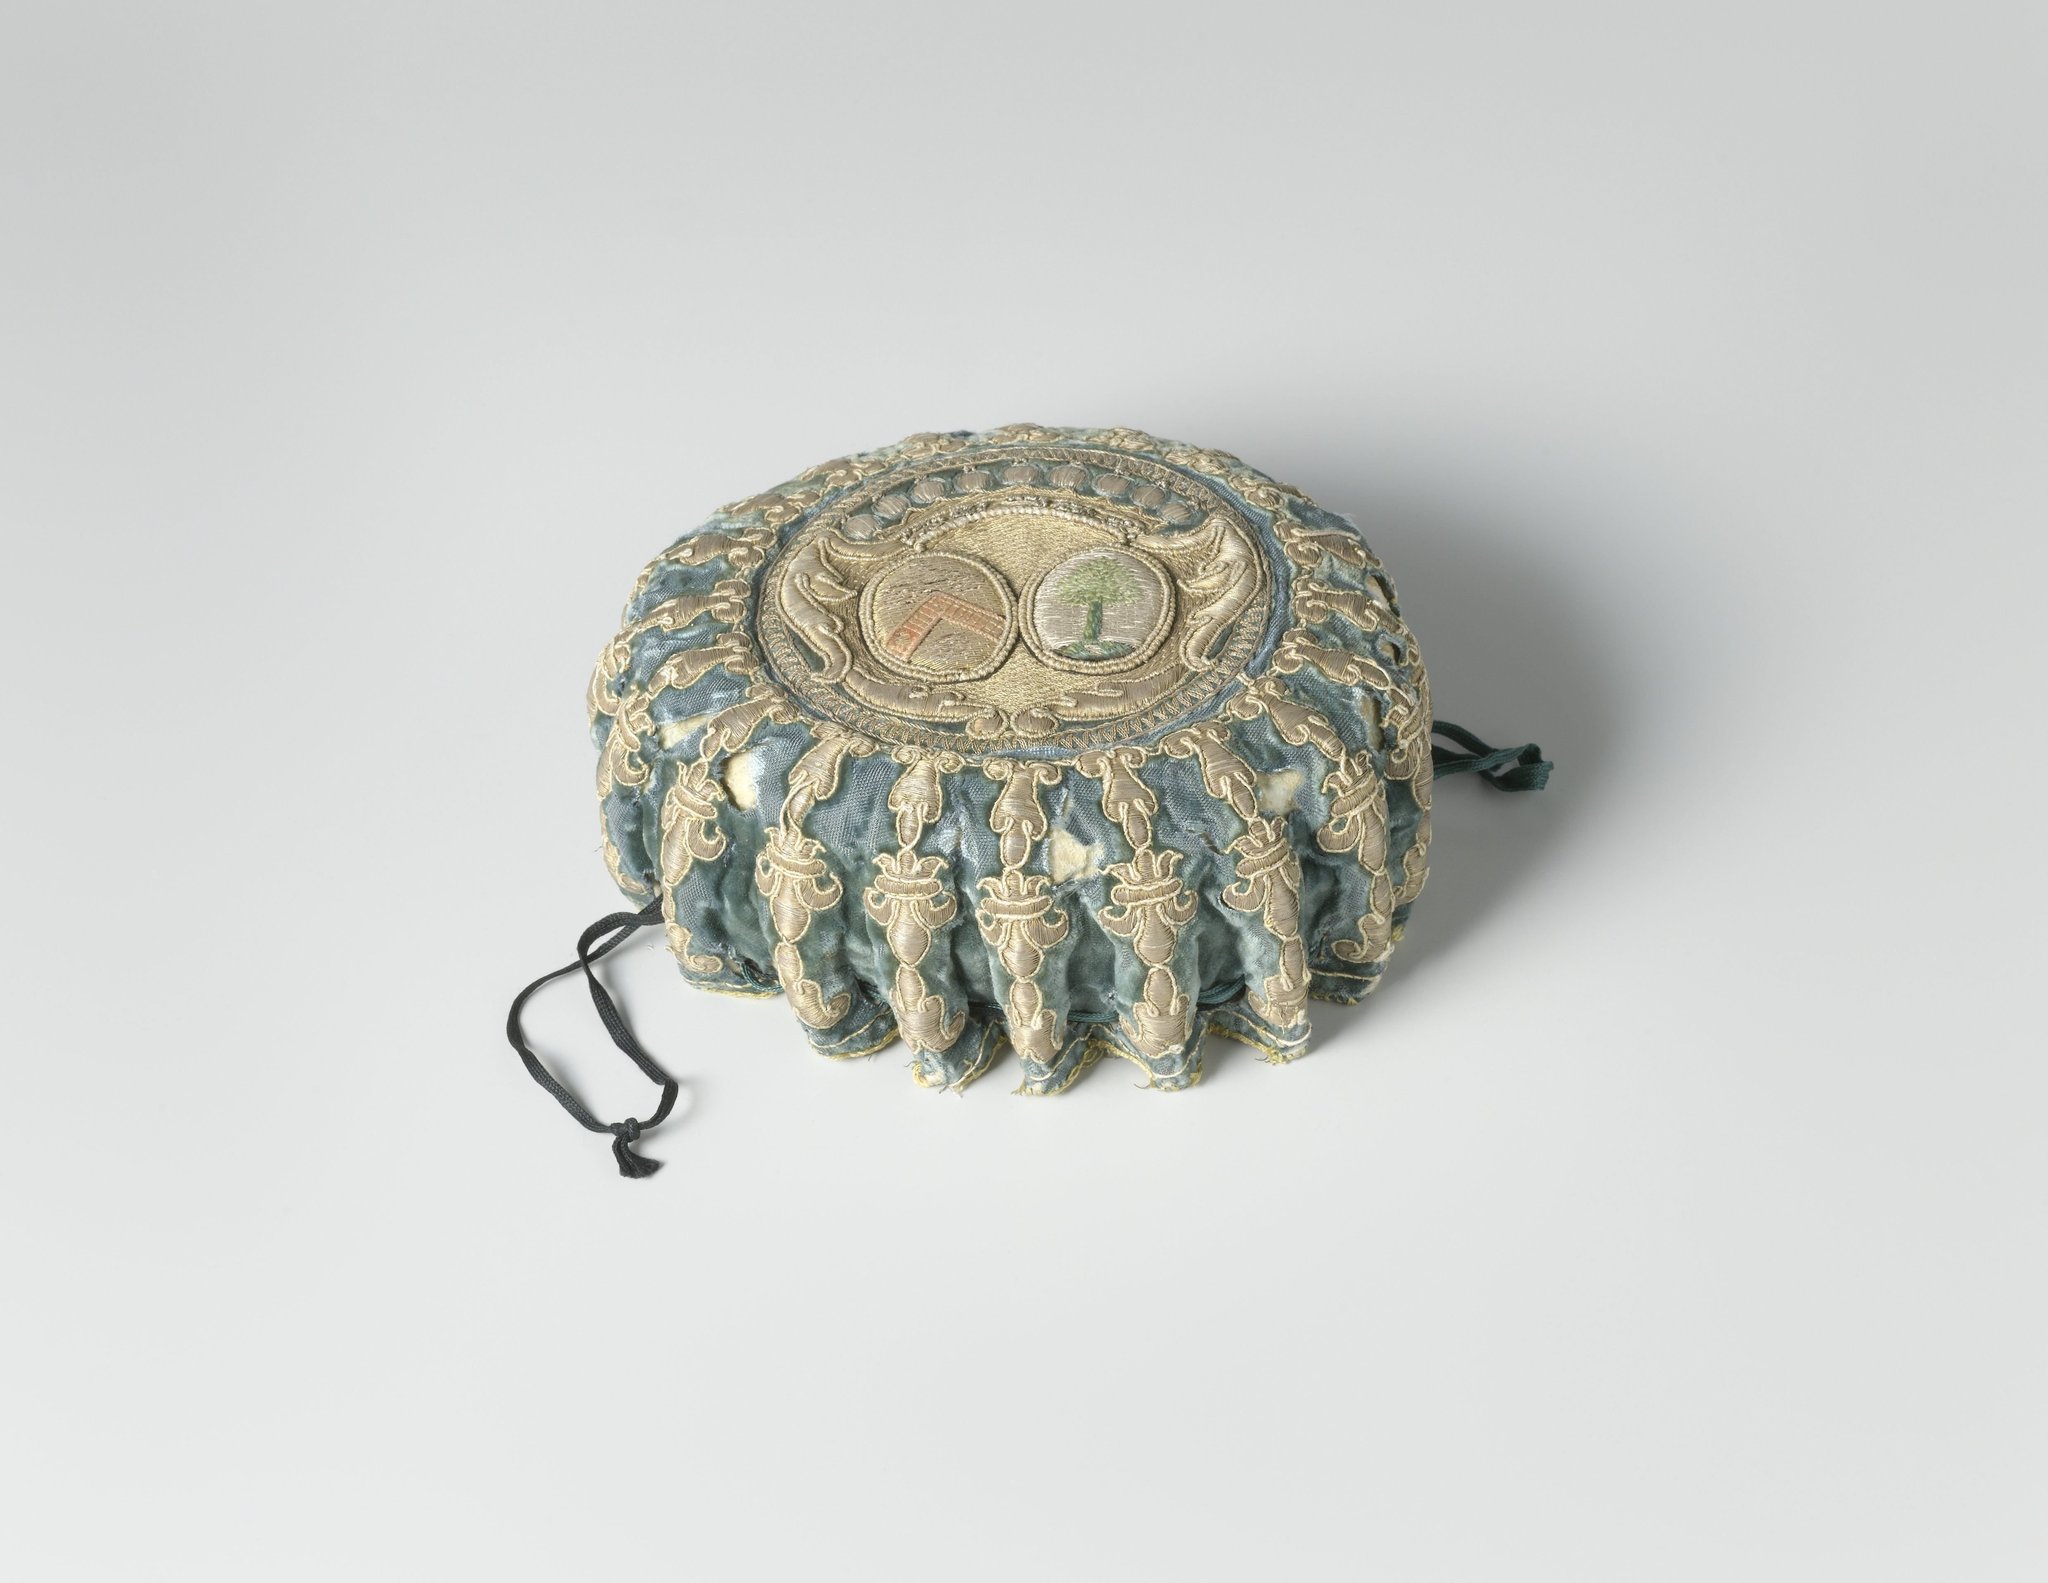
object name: speelbeurs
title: Speelbeurs van grijsblauw fluweel geborduurd met zilverdraad, op de bodem versierd met ongeïdentificeerd alliantiewapen in goud- en zilverbrokaat en veelkleurige zijde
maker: Anonymous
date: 1680-1720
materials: leather, thread, velvet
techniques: spinning, tanning, weave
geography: france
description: Speelbeurs van grijsblauw fluweel geborduurd met zilverdraad, op de bodem versierd met ongeïdentificeerd alliantiewapen in goud- en zilverbrokaat en veelkleurige zijde. Model: platte ronde bodem waar omheen een golvende opstaande rand voorzien van gaten waardoor oorspronkelijk een koord van gevlochten zijde doorheen werd getrokken. Het koord ontbreekt. Gevoerd met geitenleer. Versiering: de 22 uitstulpingen of 'ribben' zijn versierd met gestapelde op blad staande en door blad gedekte Franse lelies van zilverdraad in reliëf. Boven de gaten loopt een horizontale lijn van zilverdraad. Langs de bovenkant was het geheel oorspronkelijk afgezet met een band van zilverdraad, nu grotendeels vergaan. De bodem is omcirkeld met een dubbele rand waarbinnen een zigzaglijn van zilverdraad. Hierin een lambrequin van goudbrokaat met twee ovale wapenschilden waarop links een rozerode keper op goud en rechts een groene boom op een grondje, op zilver.